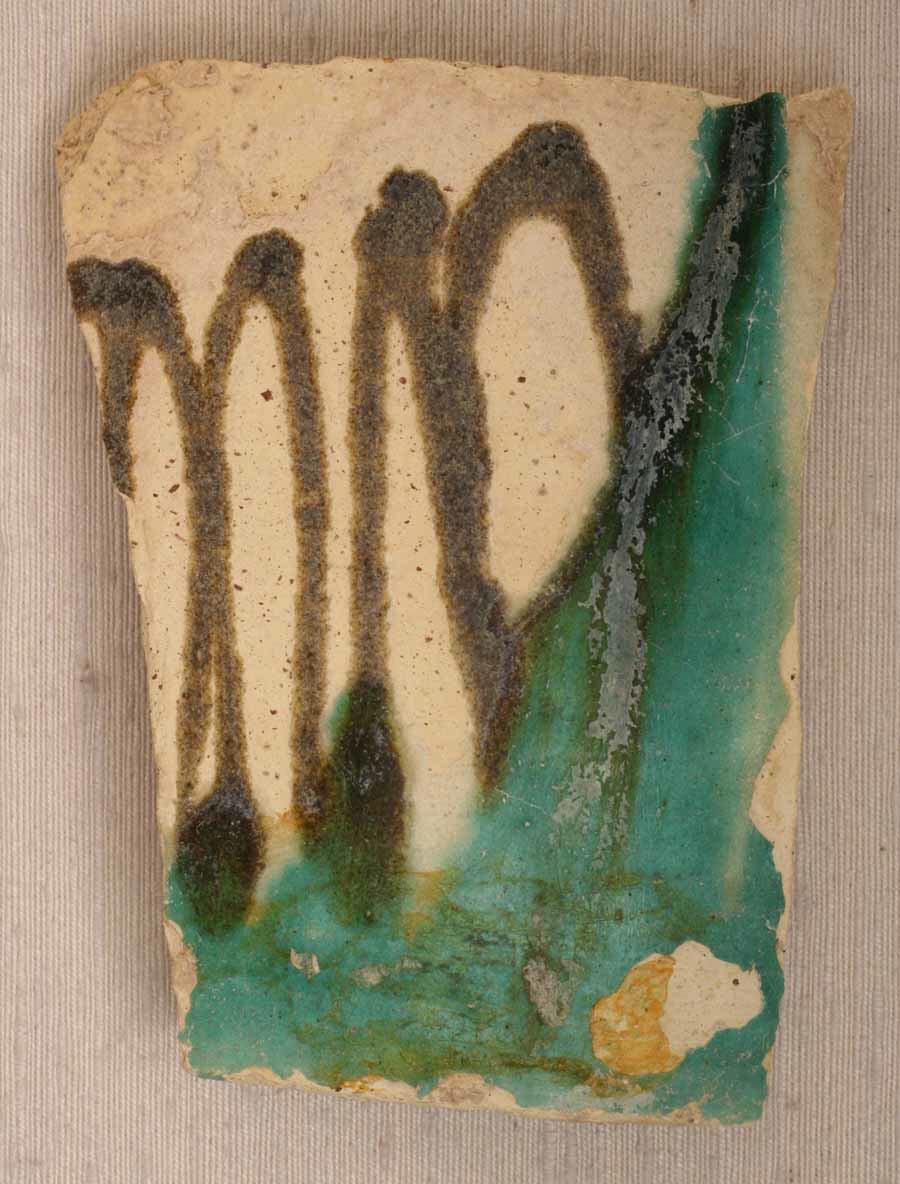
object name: fragment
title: Ceramic Fragment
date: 801-900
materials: earthenware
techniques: glazing, molding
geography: saudi arabia